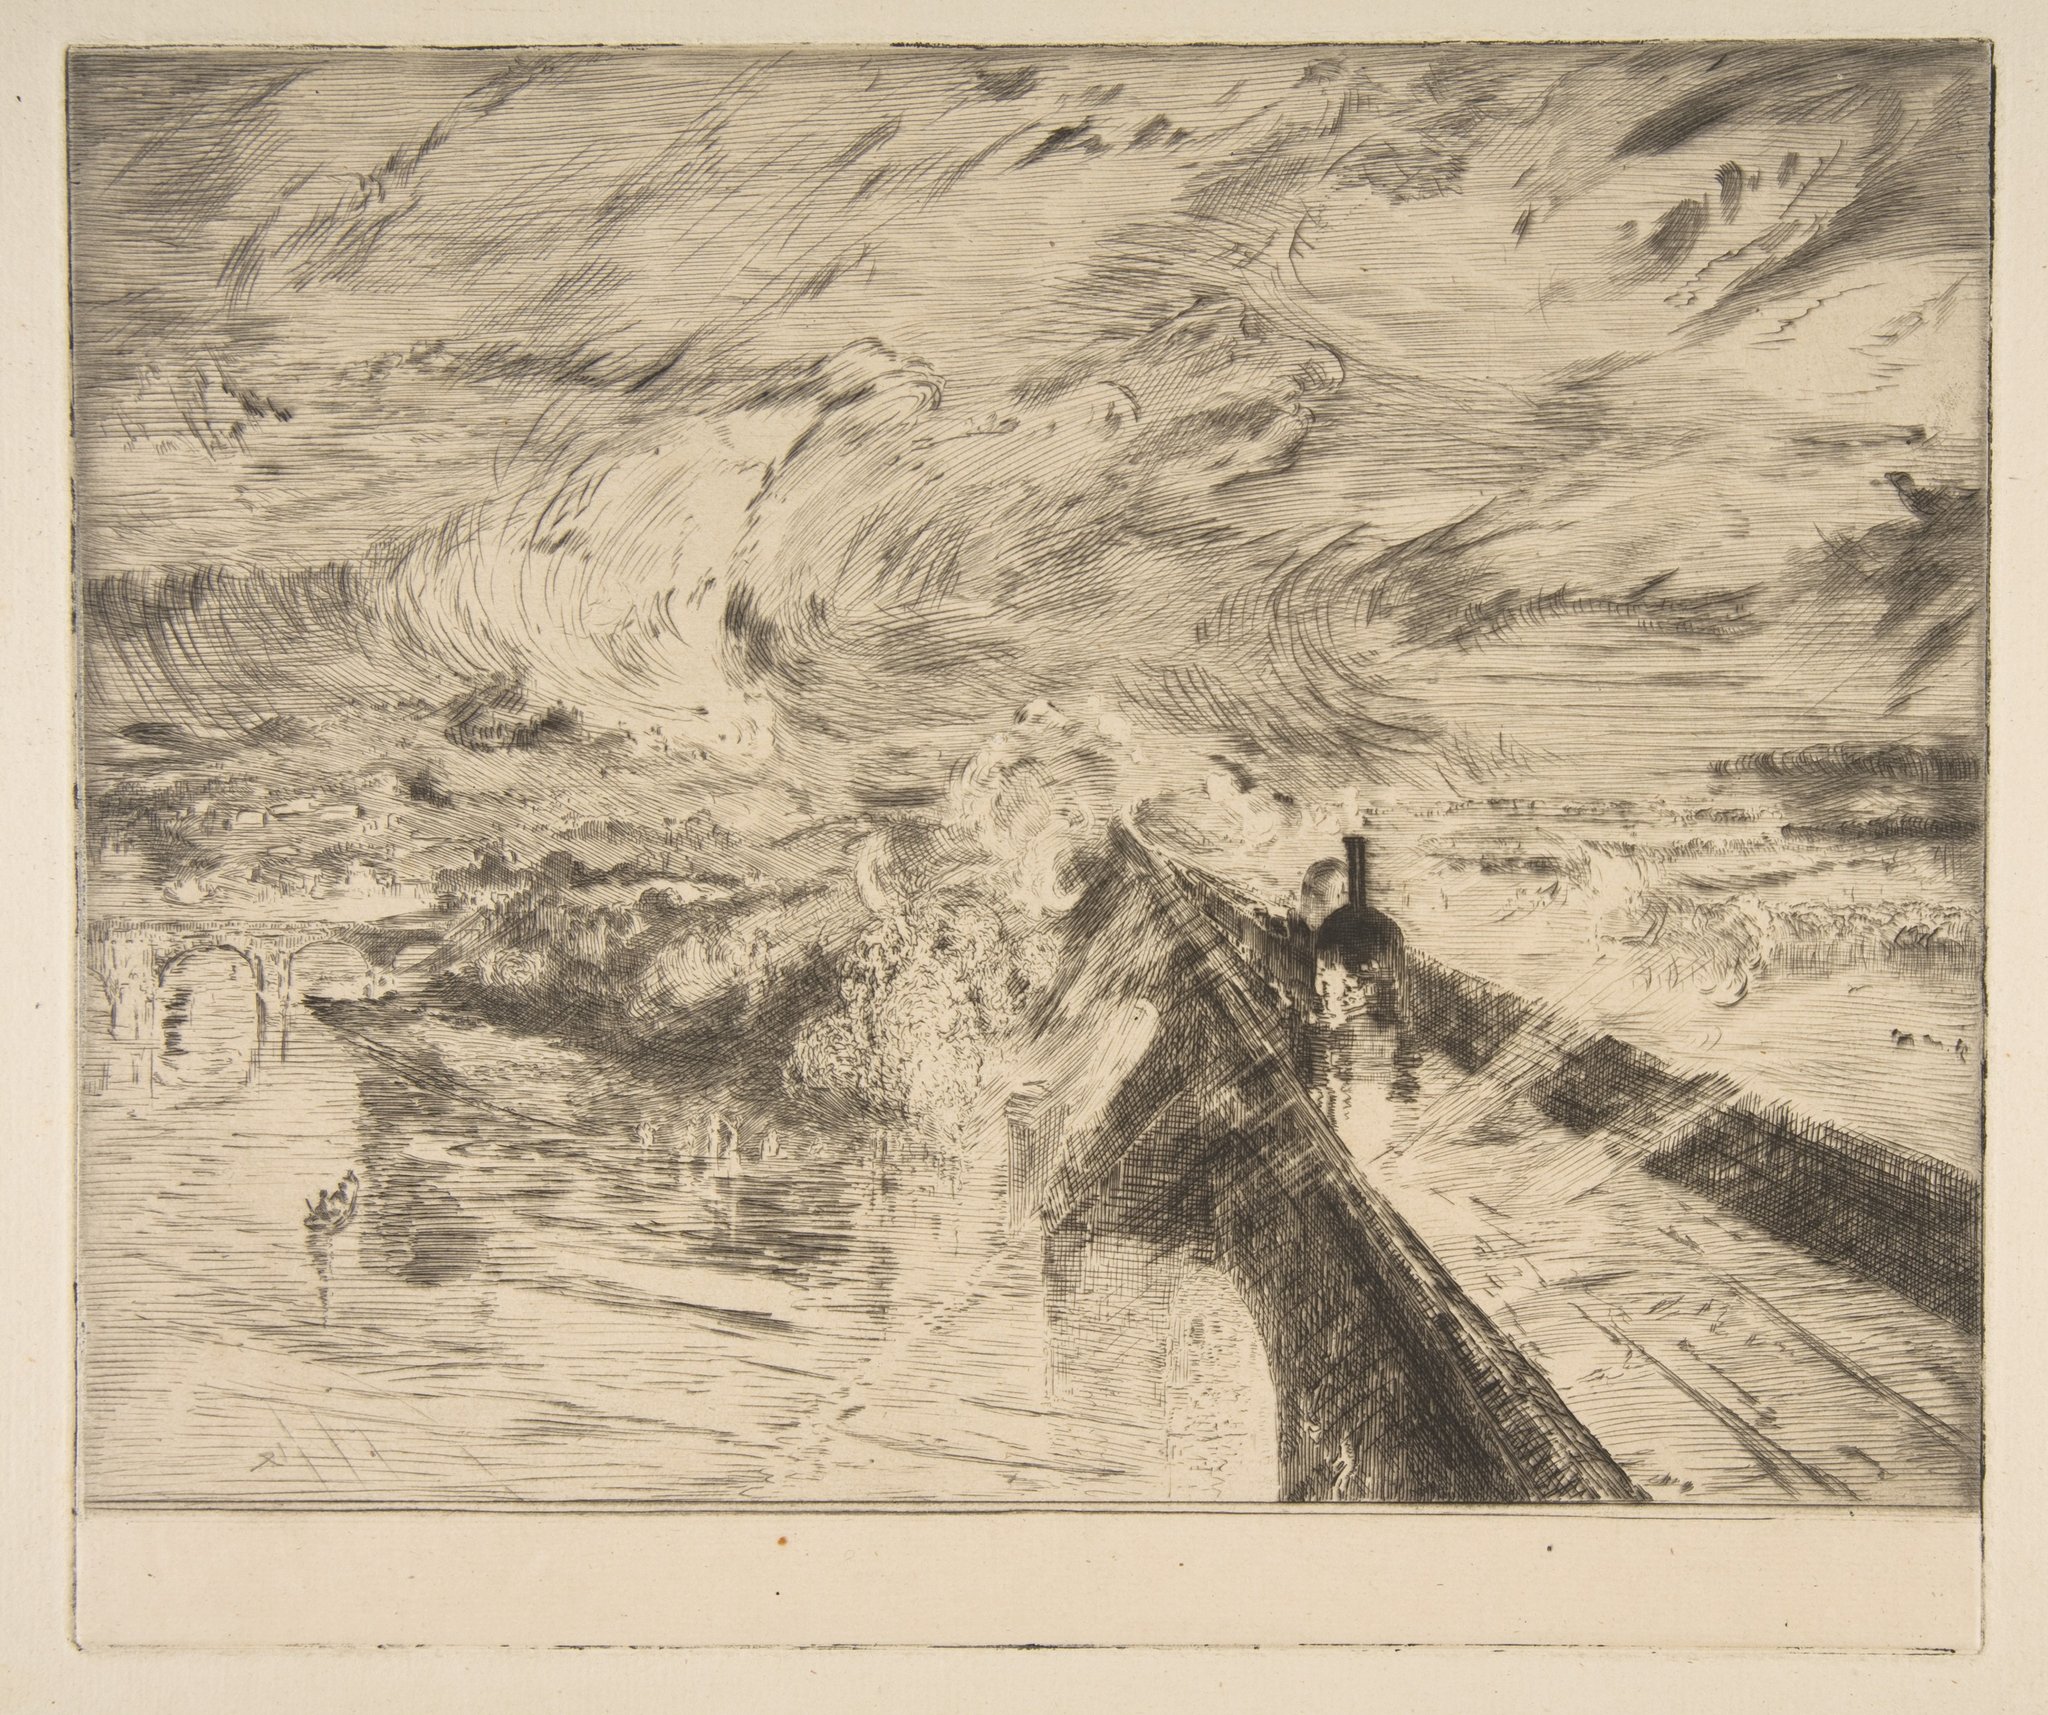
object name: print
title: La Locomotive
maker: félix bracquemond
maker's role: artist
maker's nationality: french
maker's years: 1833-1914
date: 1873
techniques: drypoint, etching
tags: bridges,trains